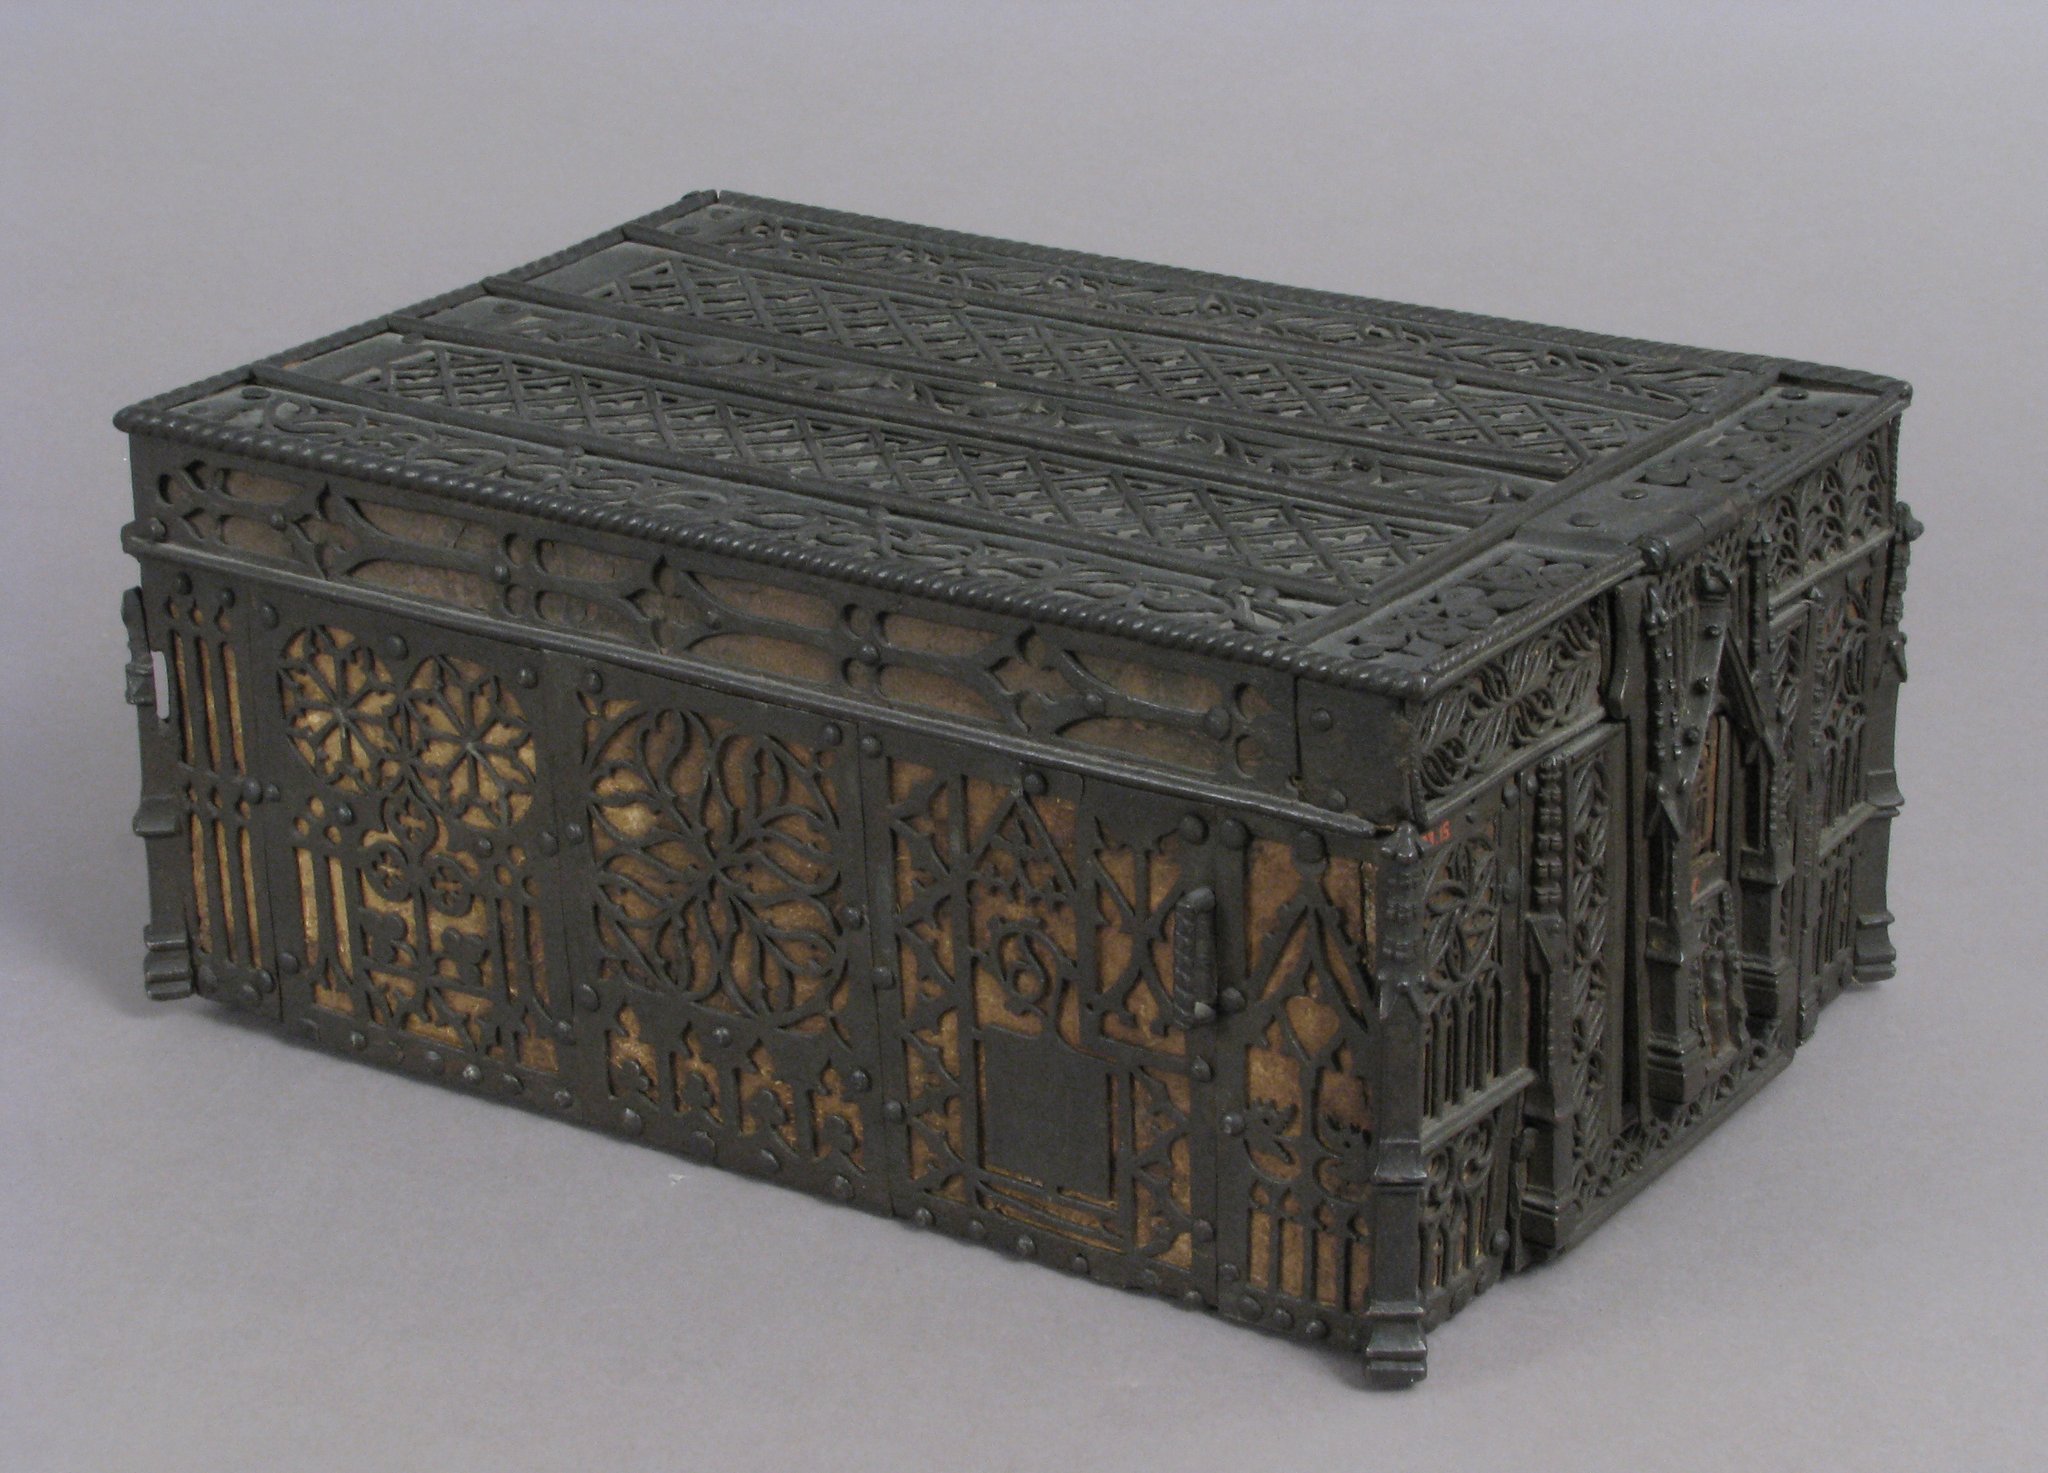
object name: coffer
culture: french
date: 1401-1500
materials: iron, leather, wood